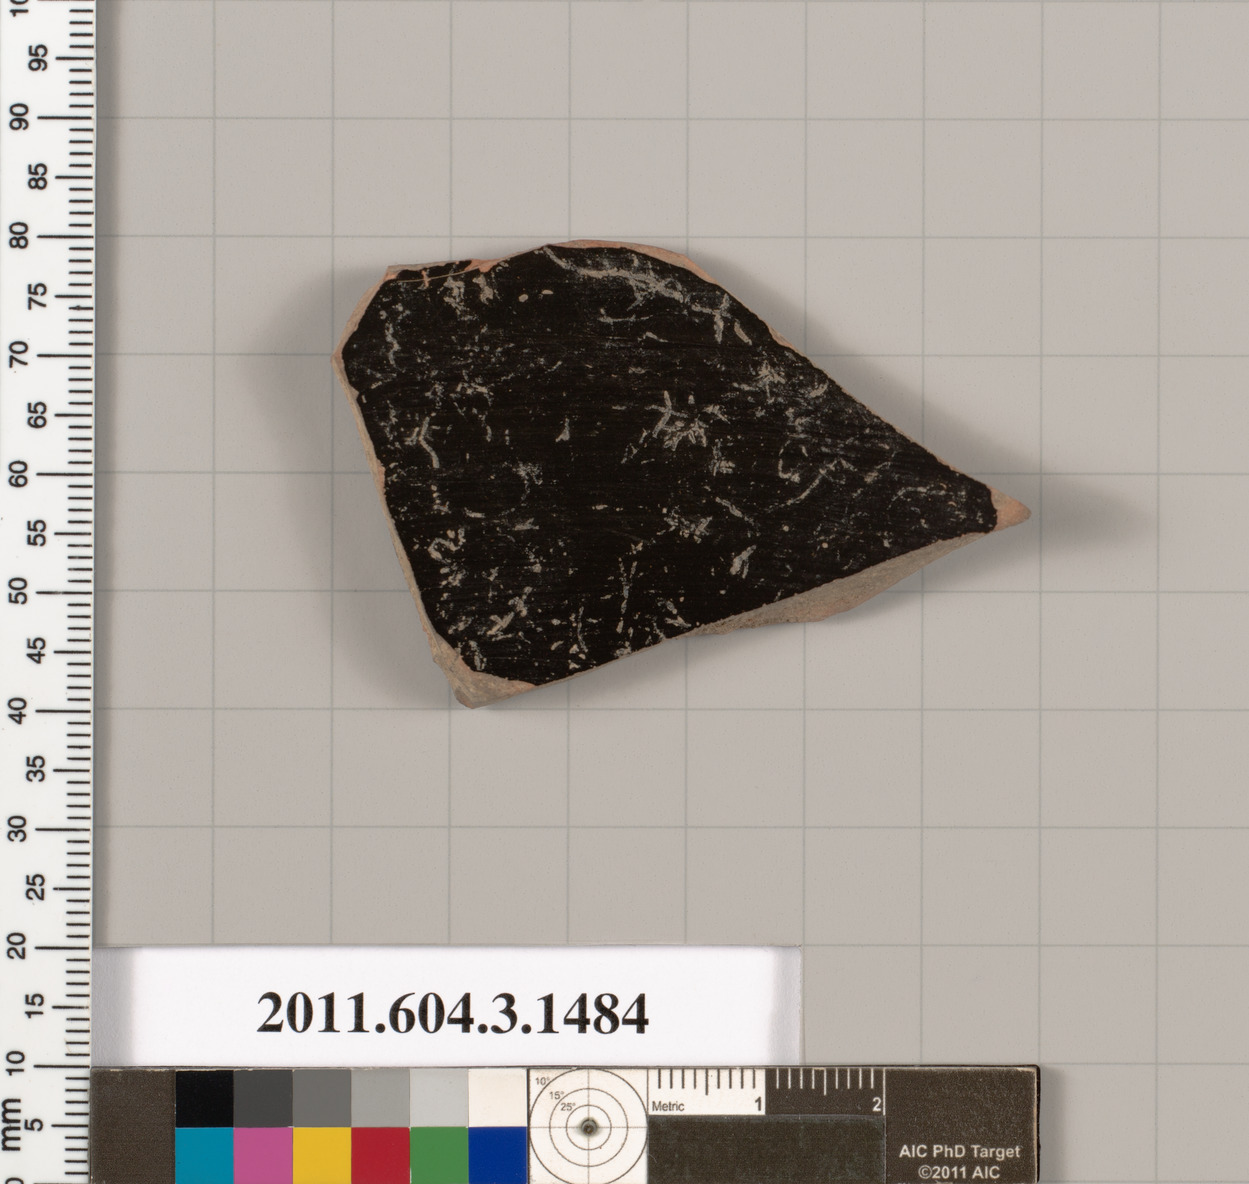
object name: skyphos fragment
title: Terracotta fragment of a skyphos (deep drinking cup)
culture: greek, attic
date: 600-401 BCE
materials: terracotta